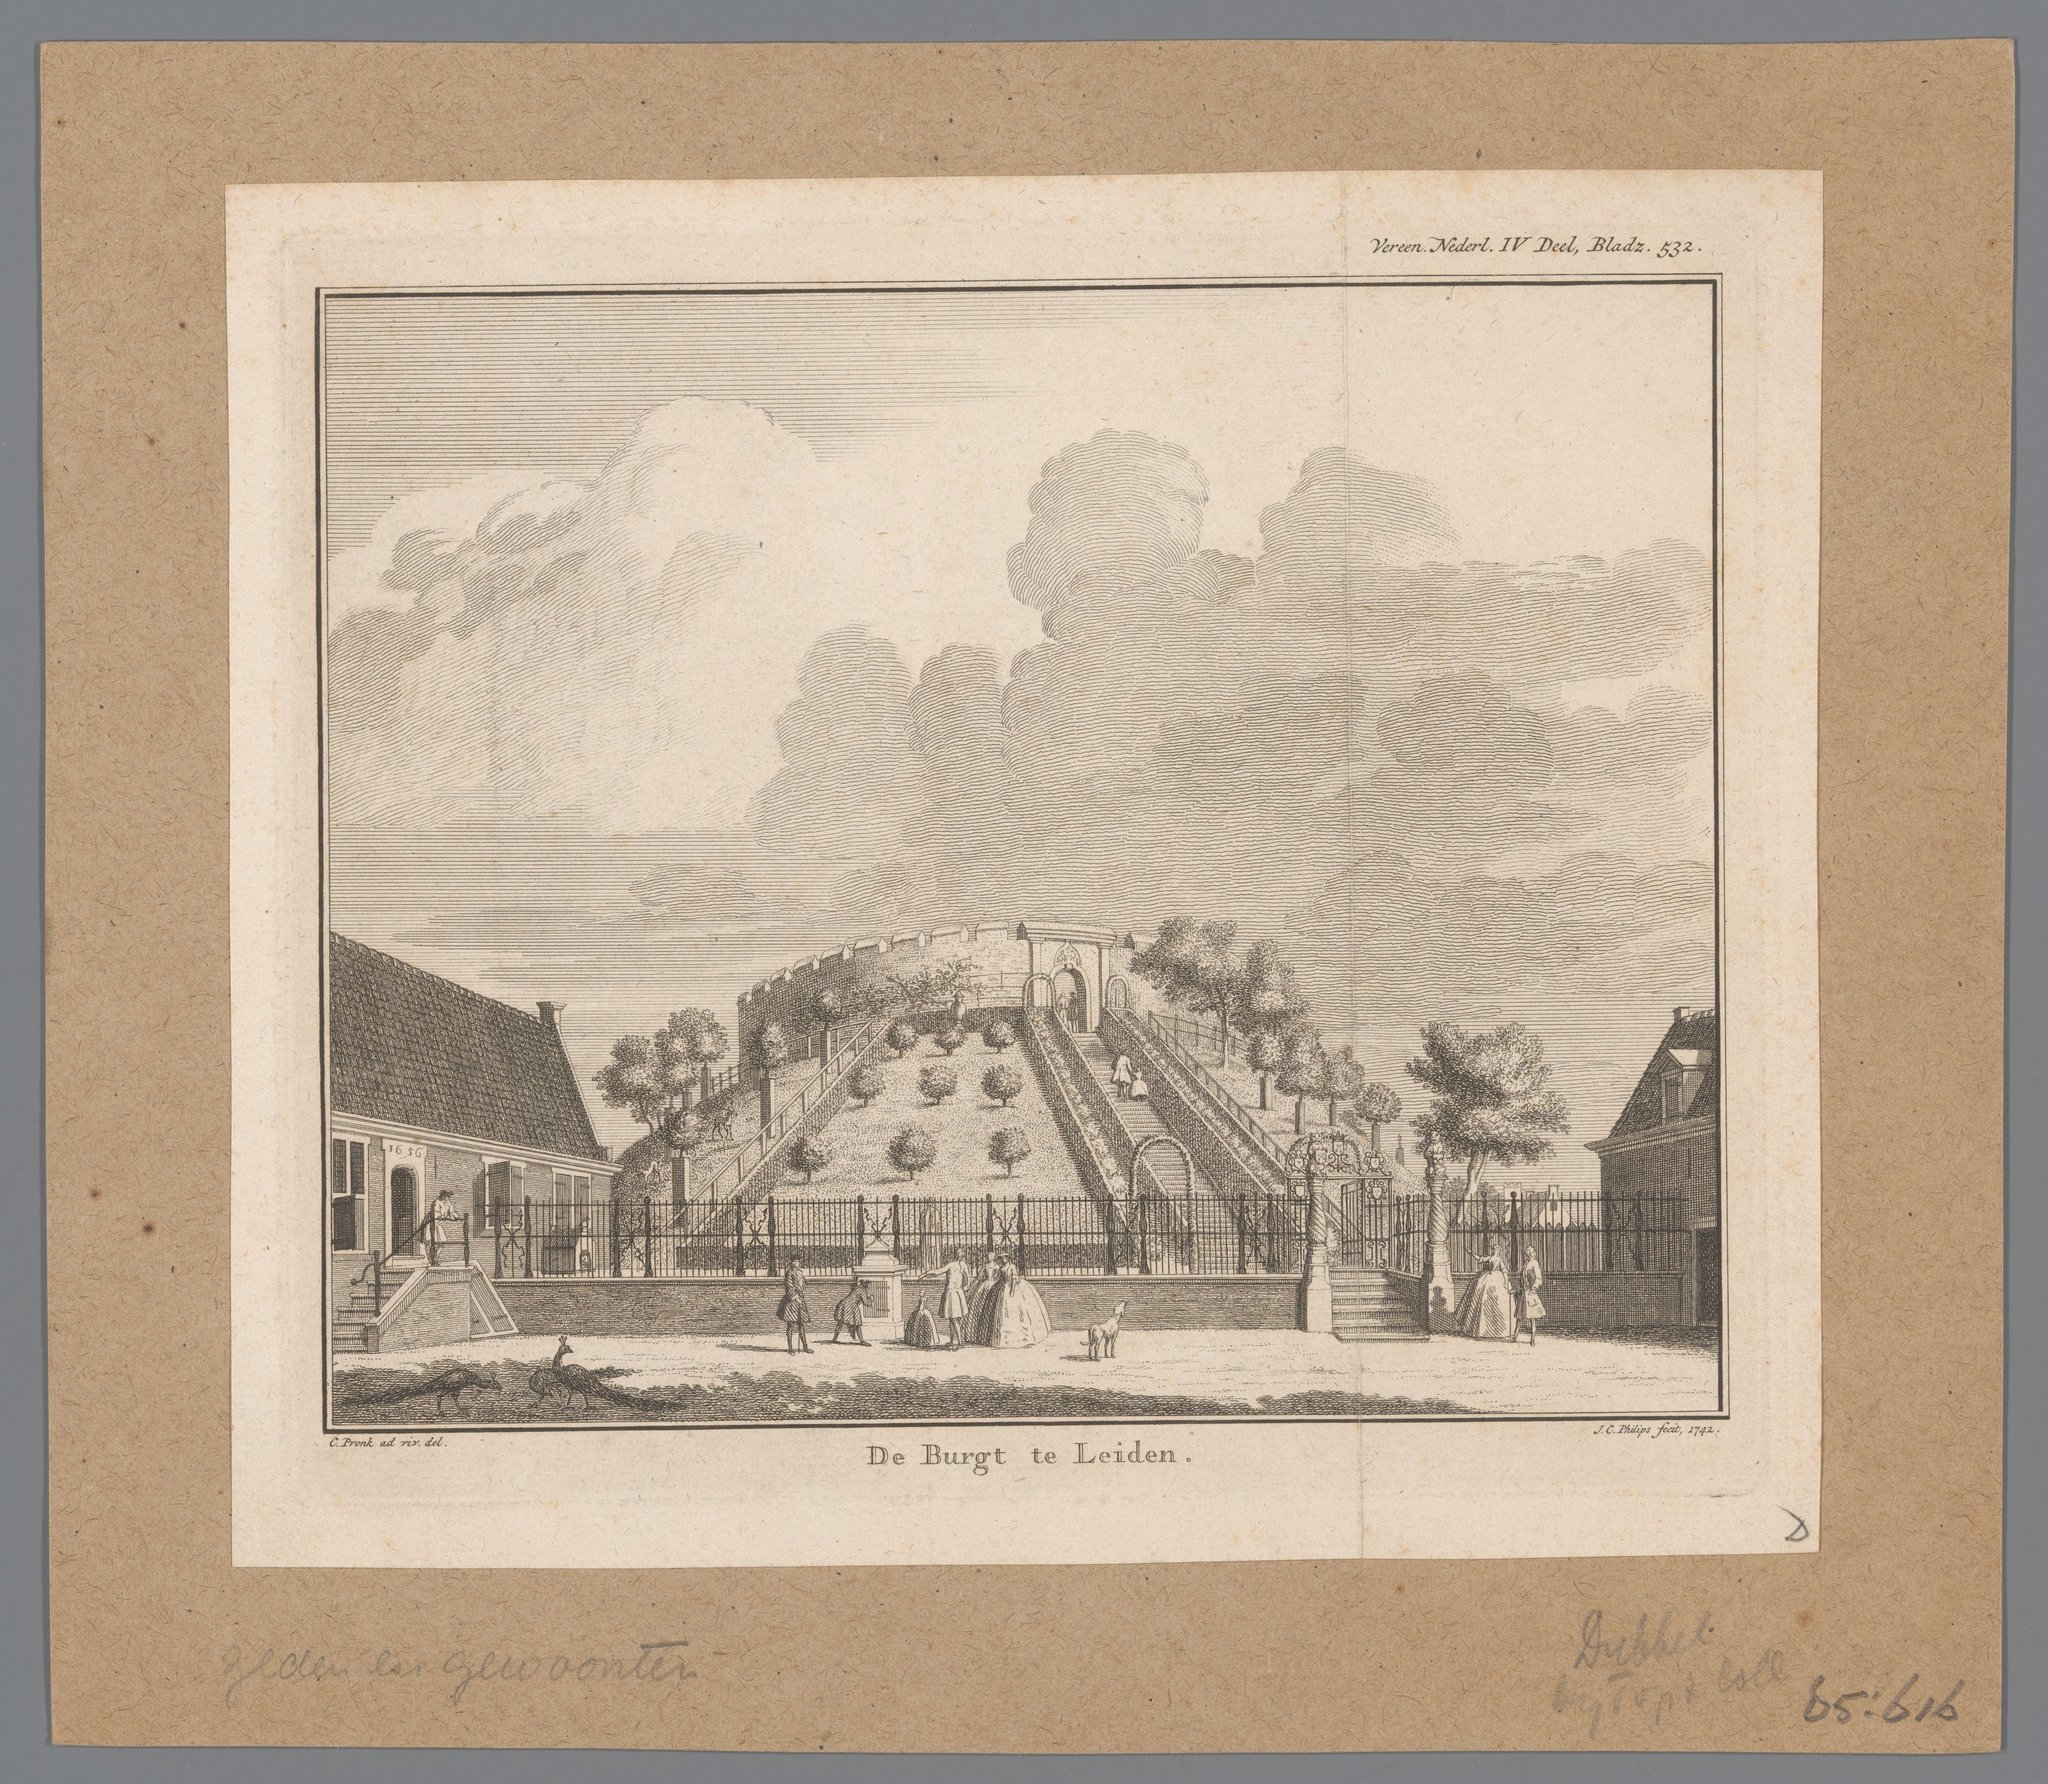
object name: book illustration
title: De burgt te Leiden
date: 1742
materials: paper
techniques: etching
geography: amsterdam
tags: fortress, street (+ city(-scape) with figures, staffage)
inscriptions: collector's mark: Lugt 2228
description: Prent uit: Wagenaar, Jan. Tegenwoordige staat der Vereenigde Nederlanden (...). Amsterdam: Isaak Tirion, 1742, dl. 4, p. 532.